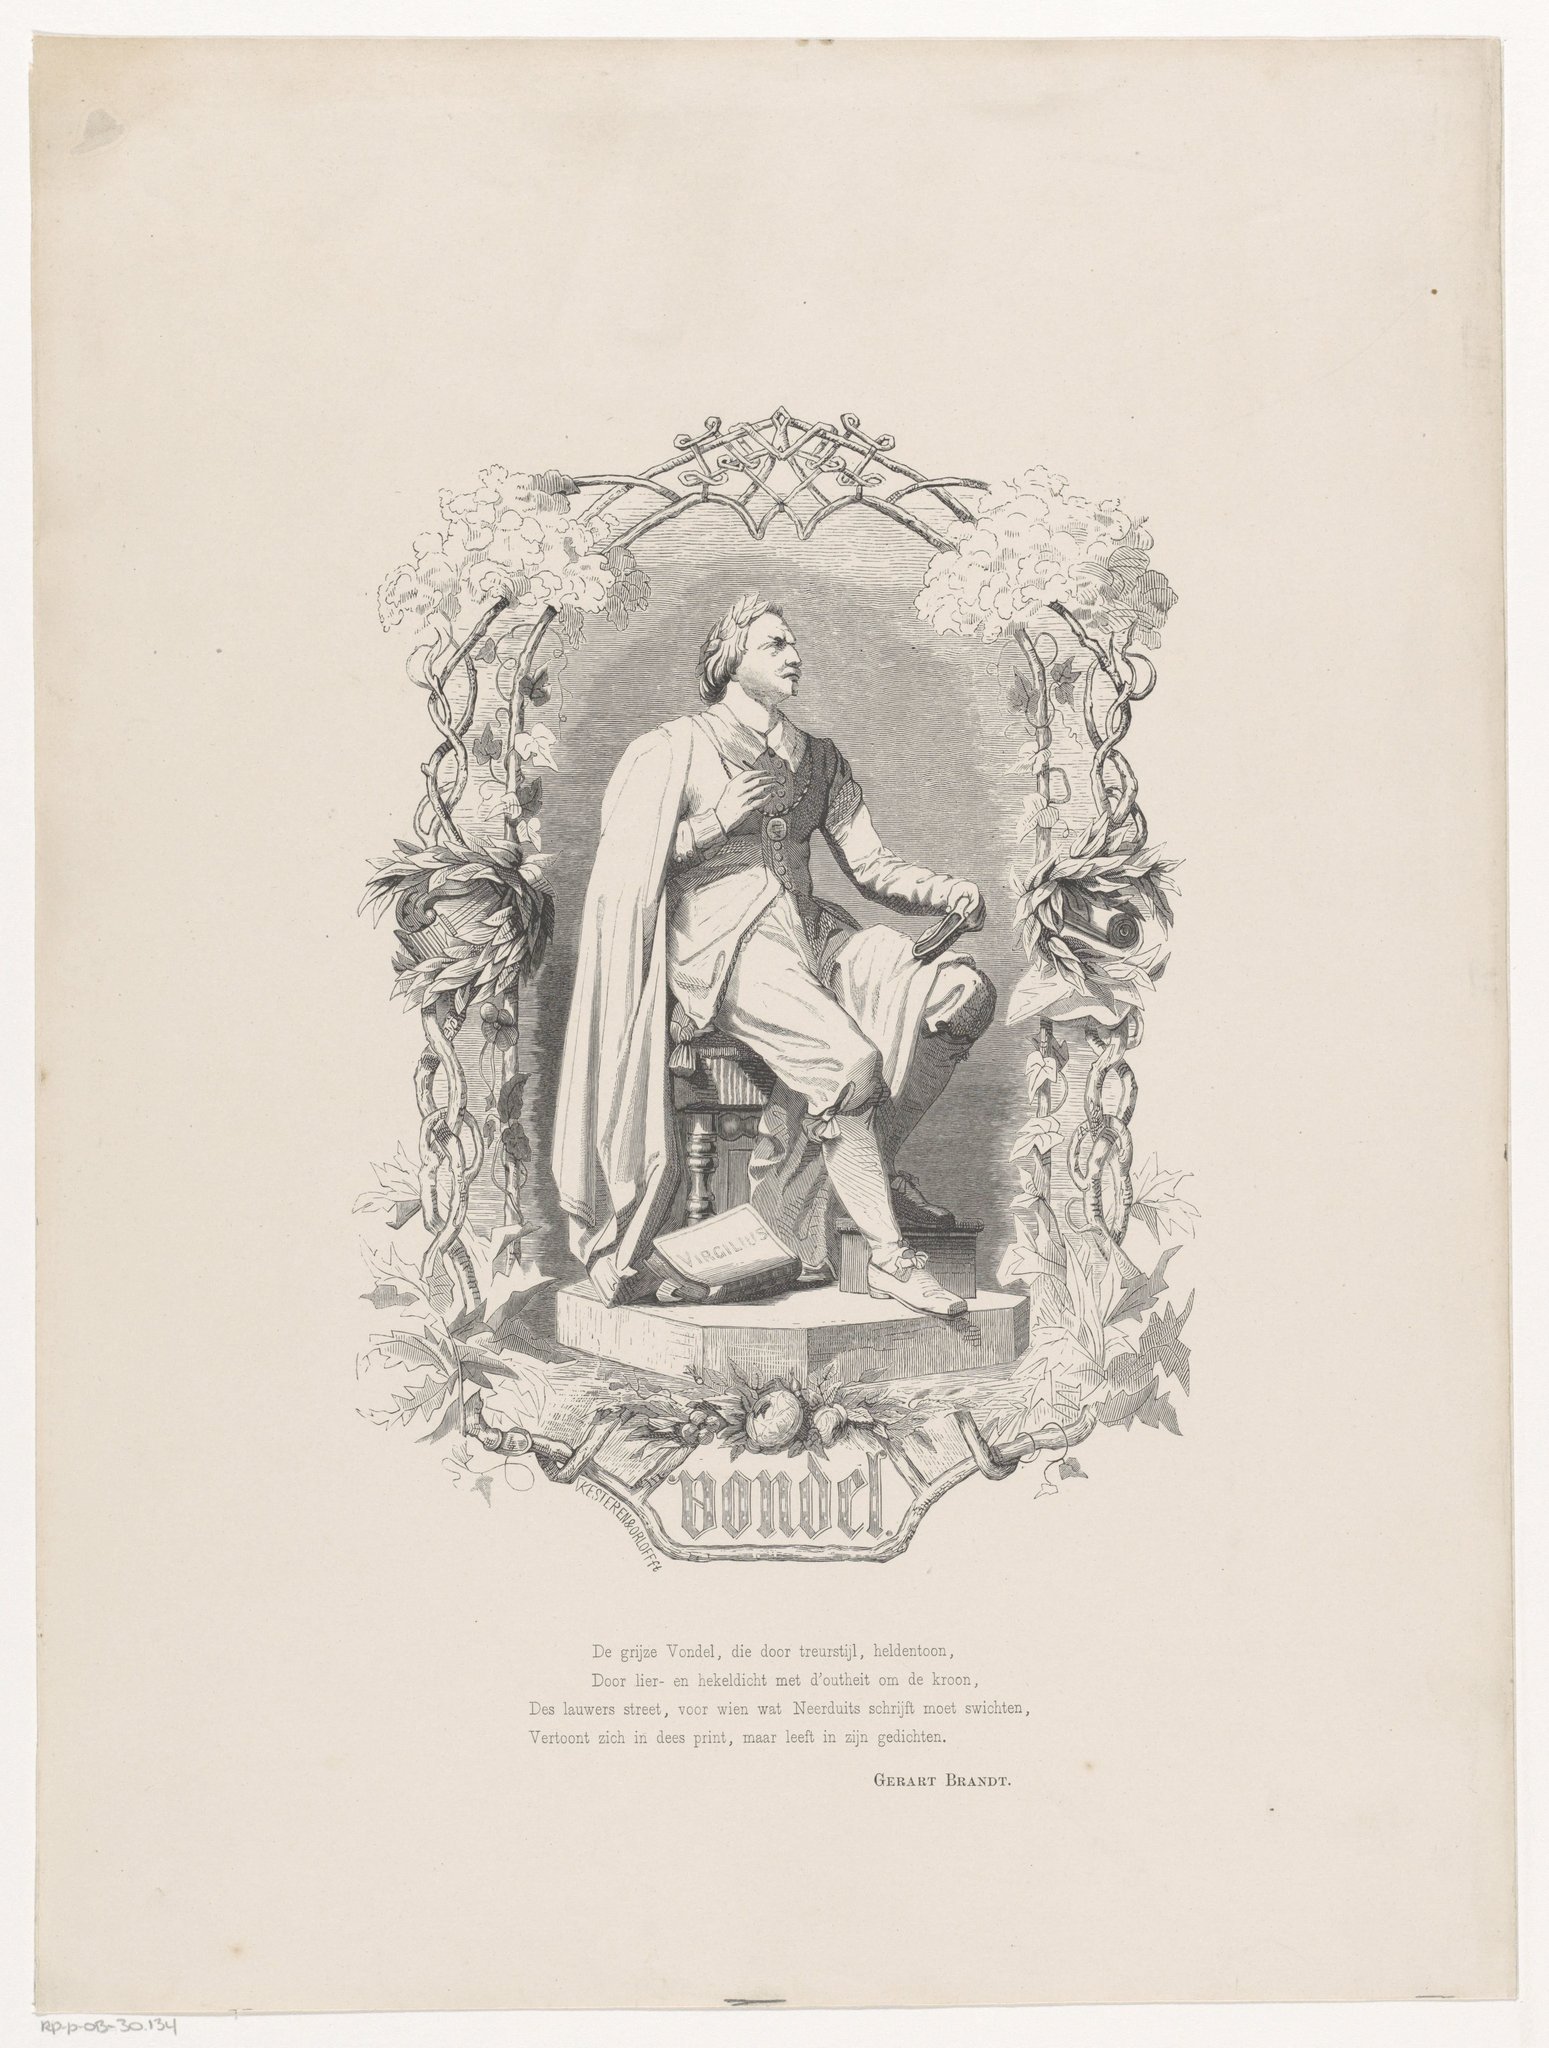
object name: print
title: Portret van Joost van den Vondel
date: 1847-1883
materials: paper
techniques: letterpress printing, engraving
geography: amsterdam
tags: cologne, amsterdam, joost van den vondel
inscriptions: collector's mark: Lugt 2228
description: Portret van Joost van den Vondel in een geornamenteerde omlijsting van bloemen en planten. Midden onder zijn naam. In de ondermarge vier regels Nederlandse tekst.